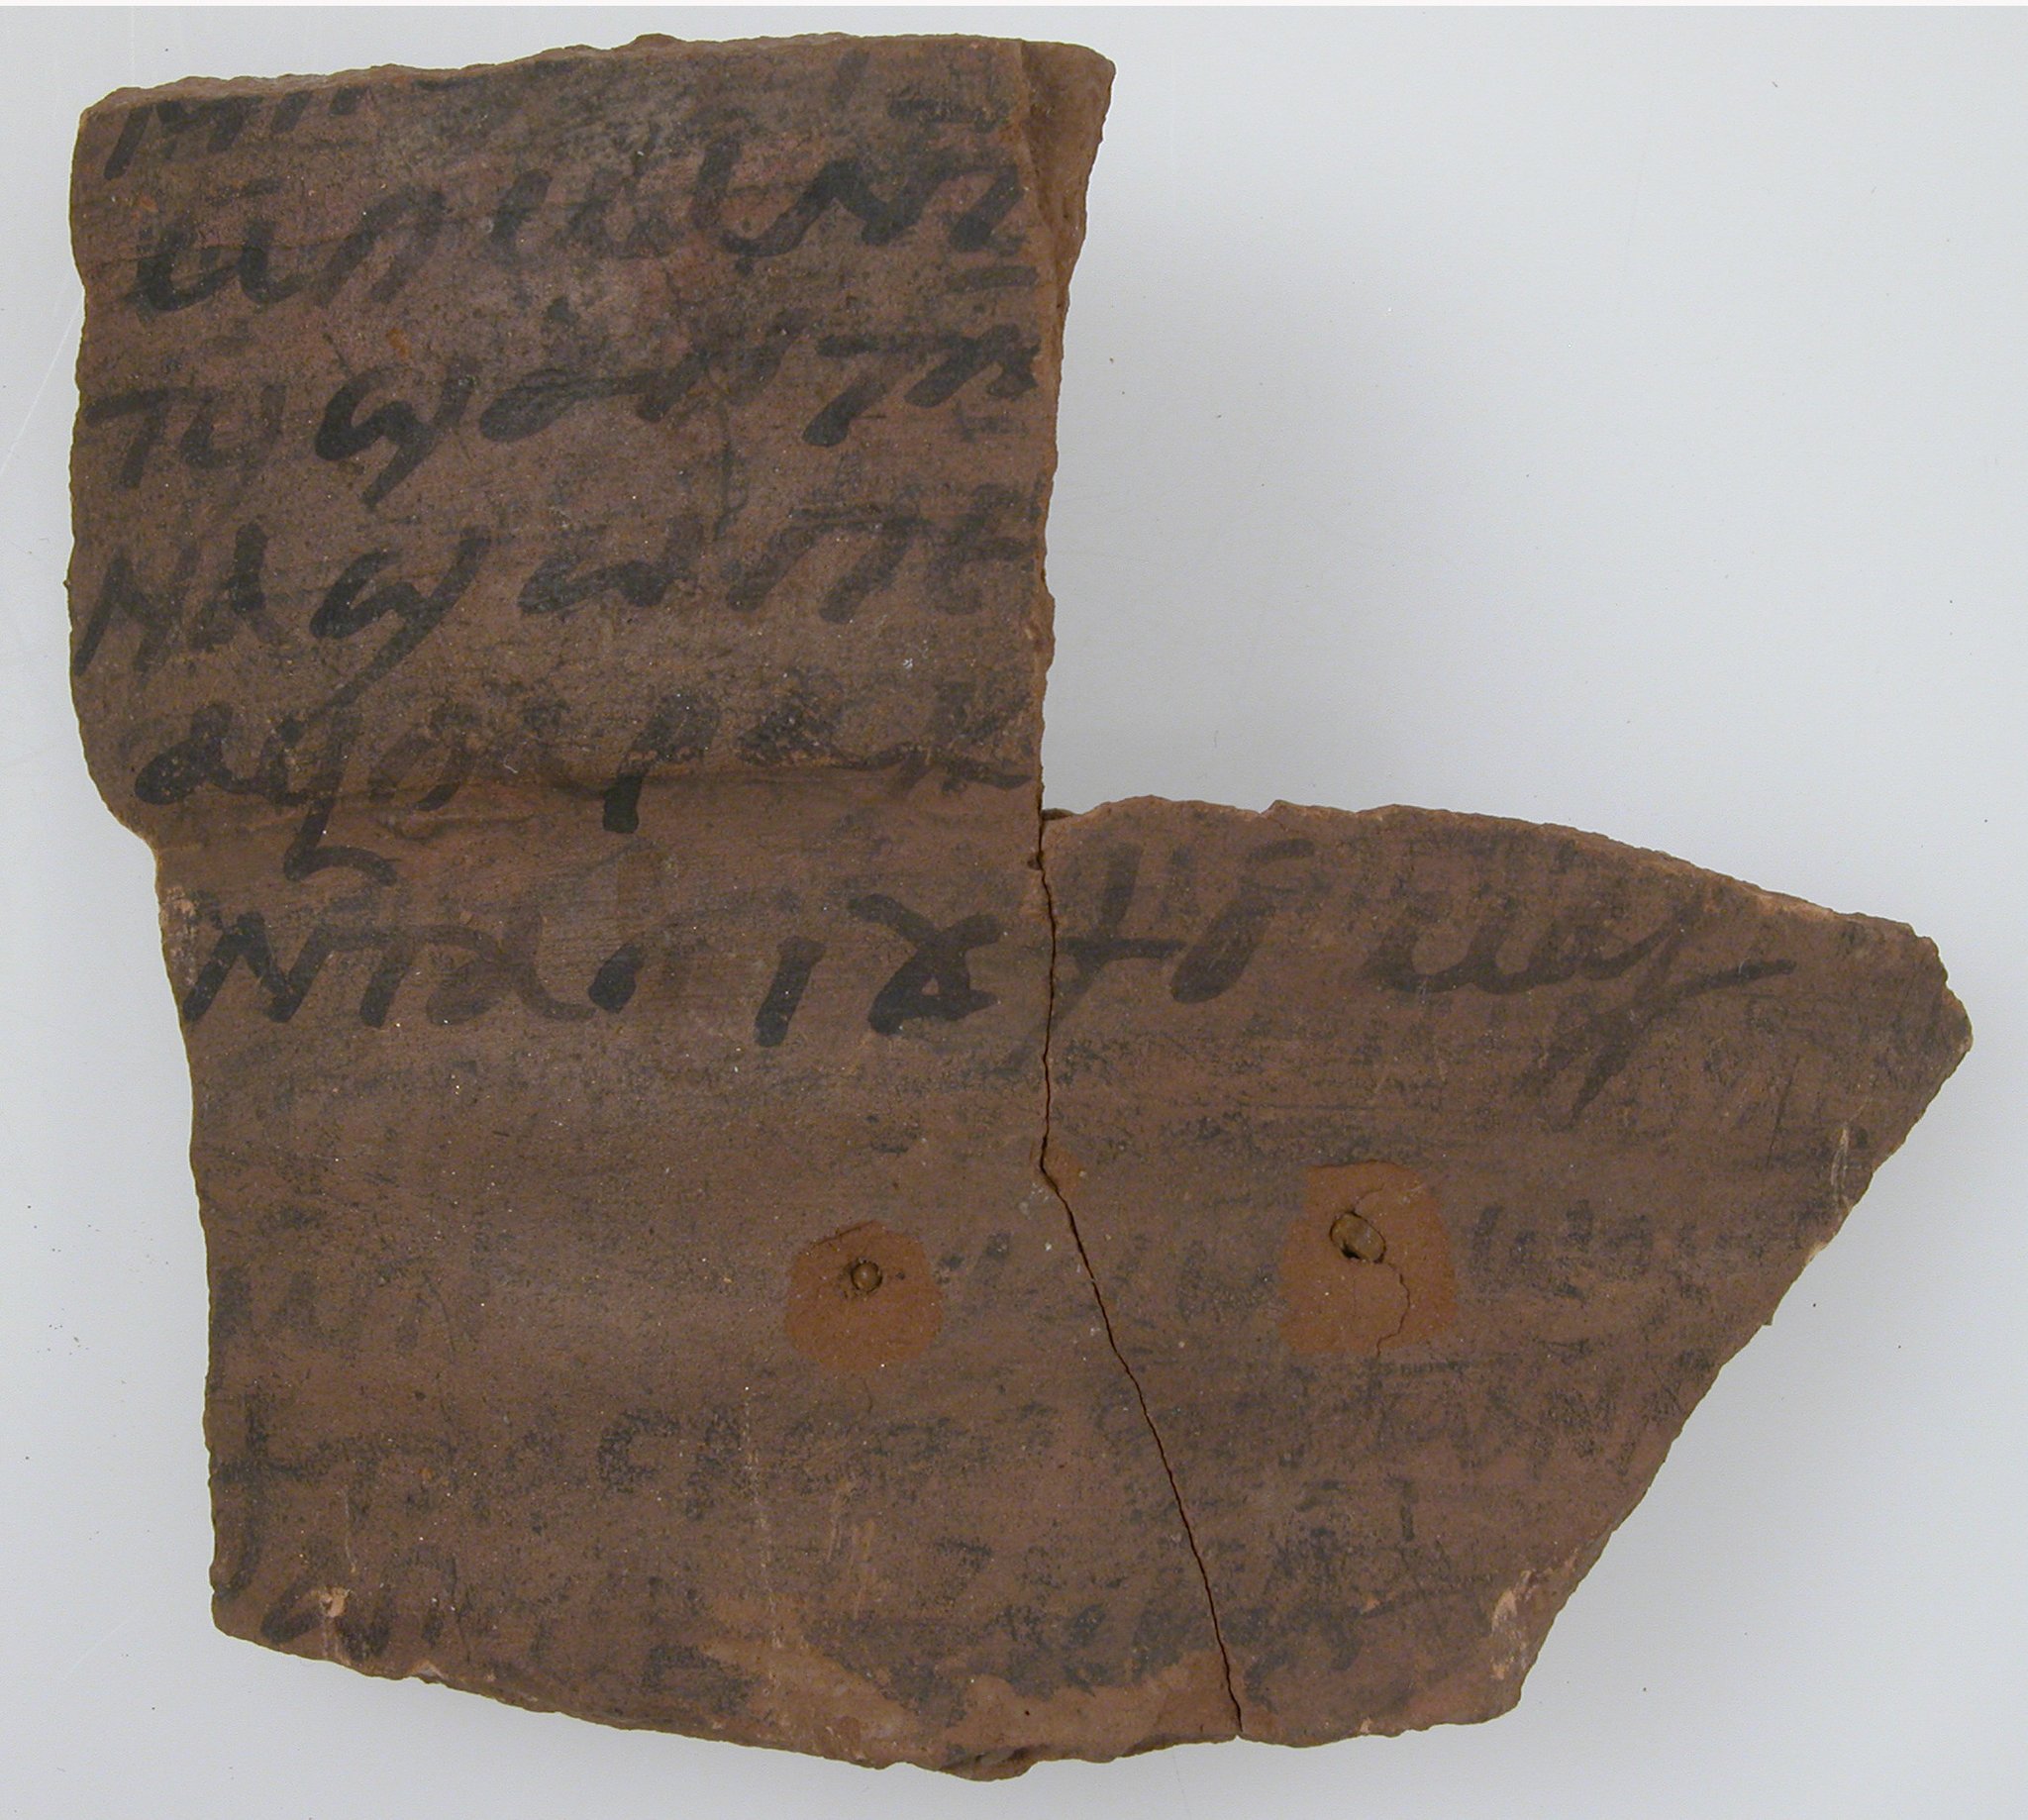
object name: ostrakon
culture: coptic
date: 601-700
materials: ink, pottery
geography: egypt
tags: coptic